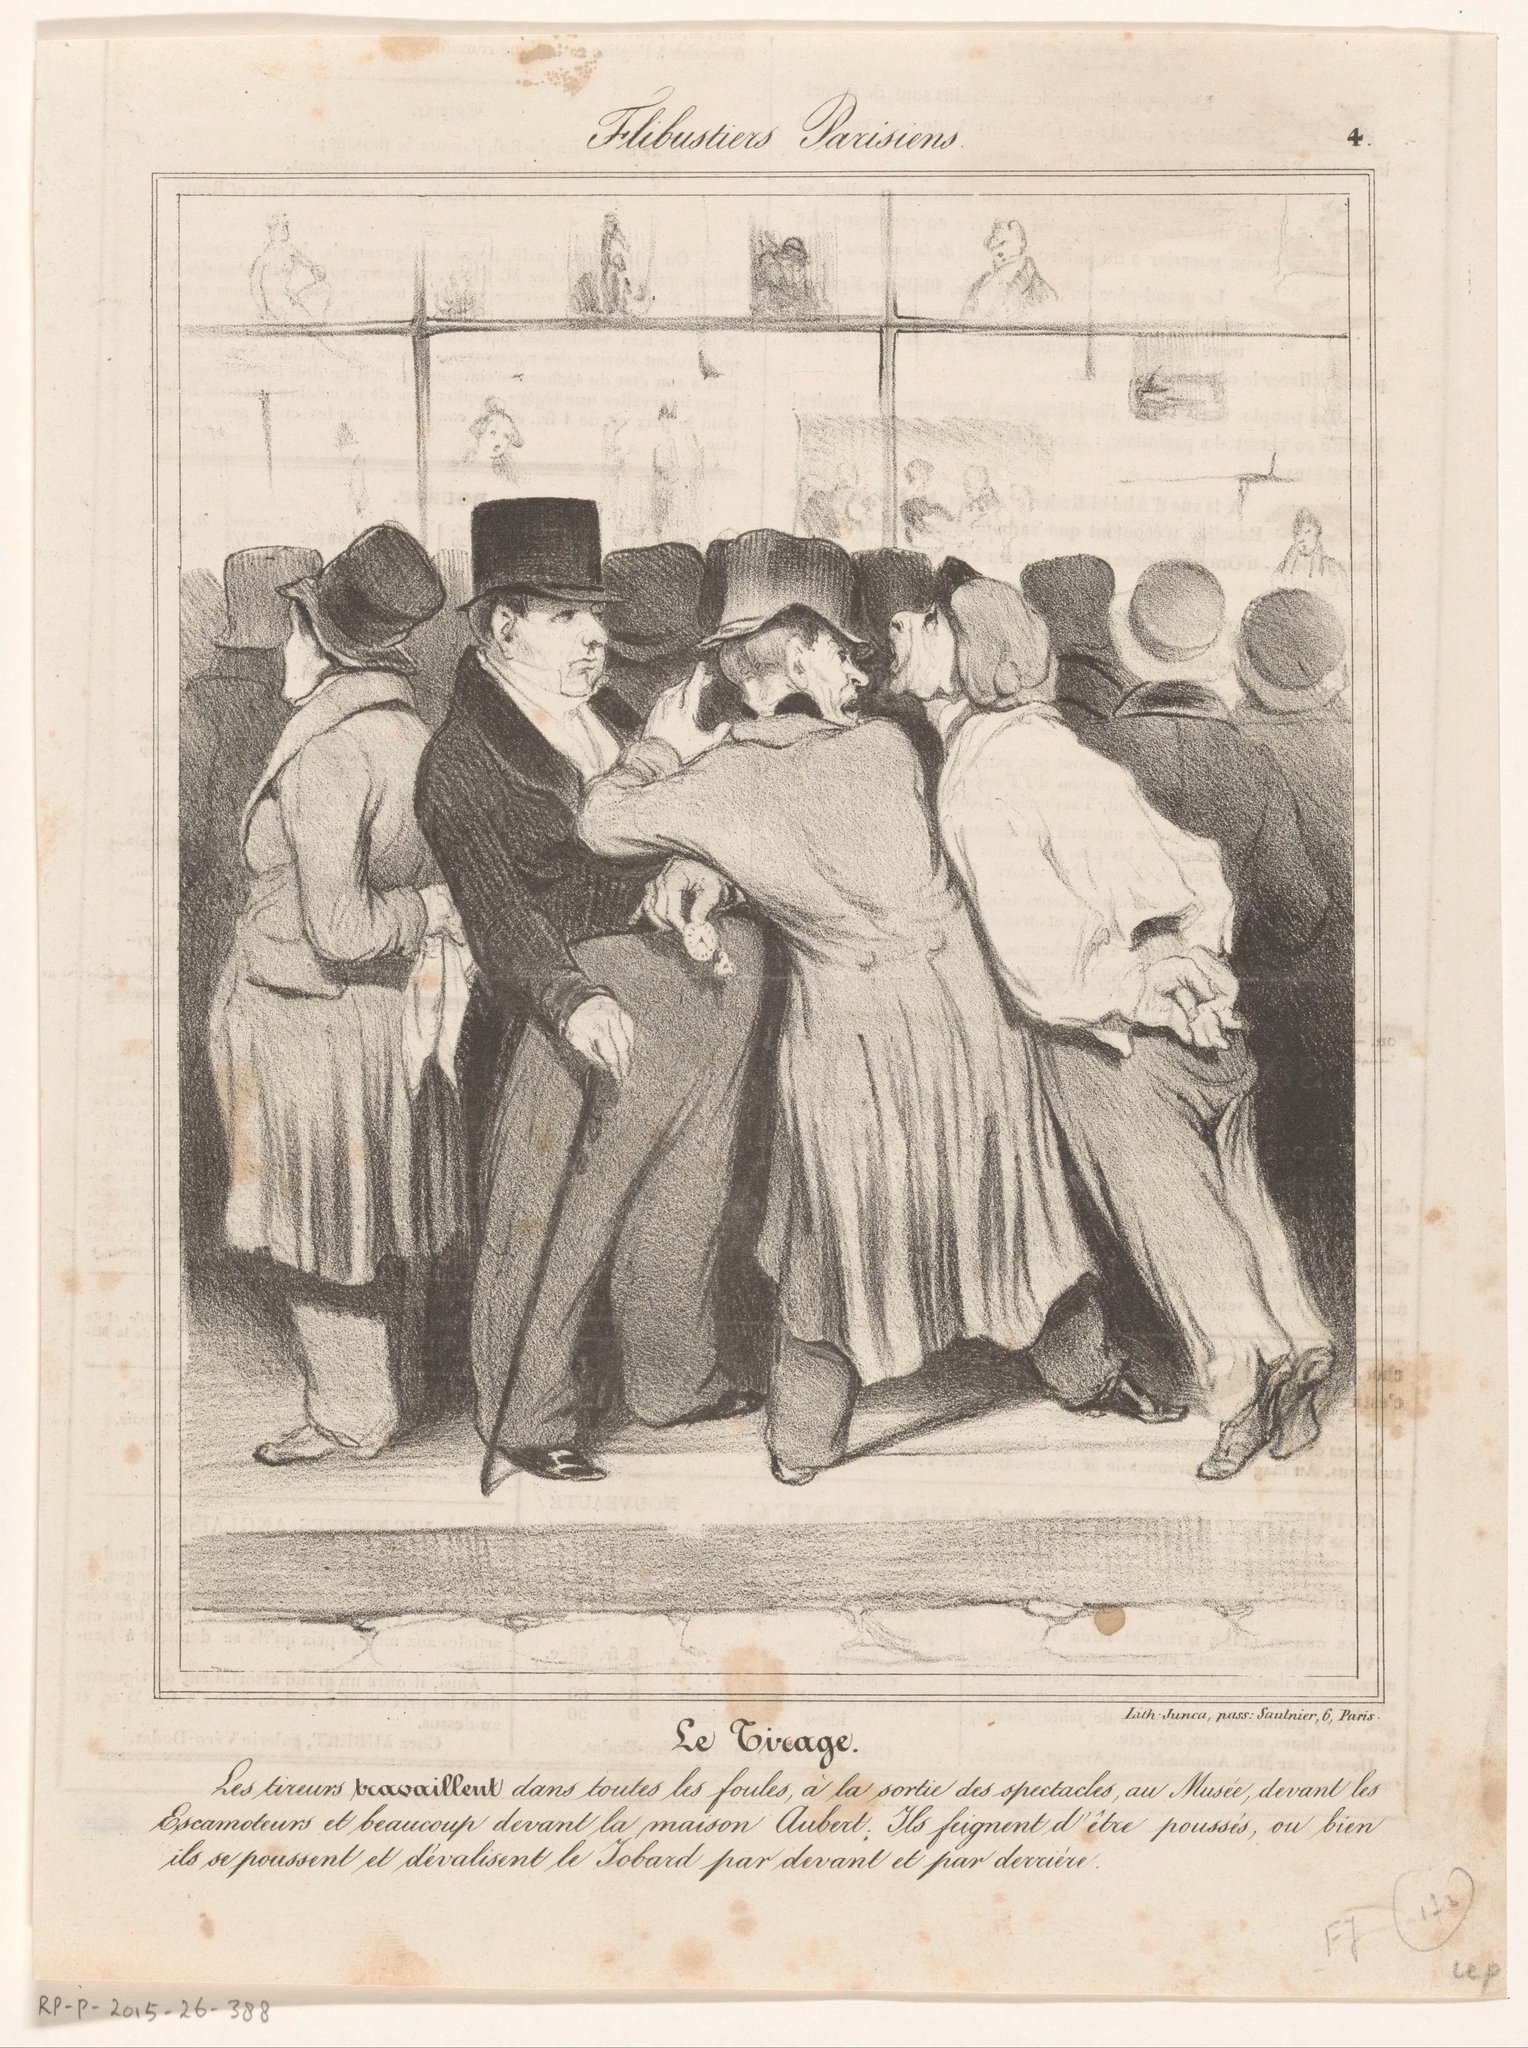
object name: print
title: Le tirage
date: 1835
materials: paper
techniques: letterpress printing, lithograph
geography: paris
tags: print, e.g.: engraving, etching, lithograph, pickpocket, publishing, publisher, shop-window, show-window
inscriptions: collector's mark: Lugt 2228, collector's mark: Lugt 4780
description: Prent afkomstig uit: Le Charivari, 20 december 1835.